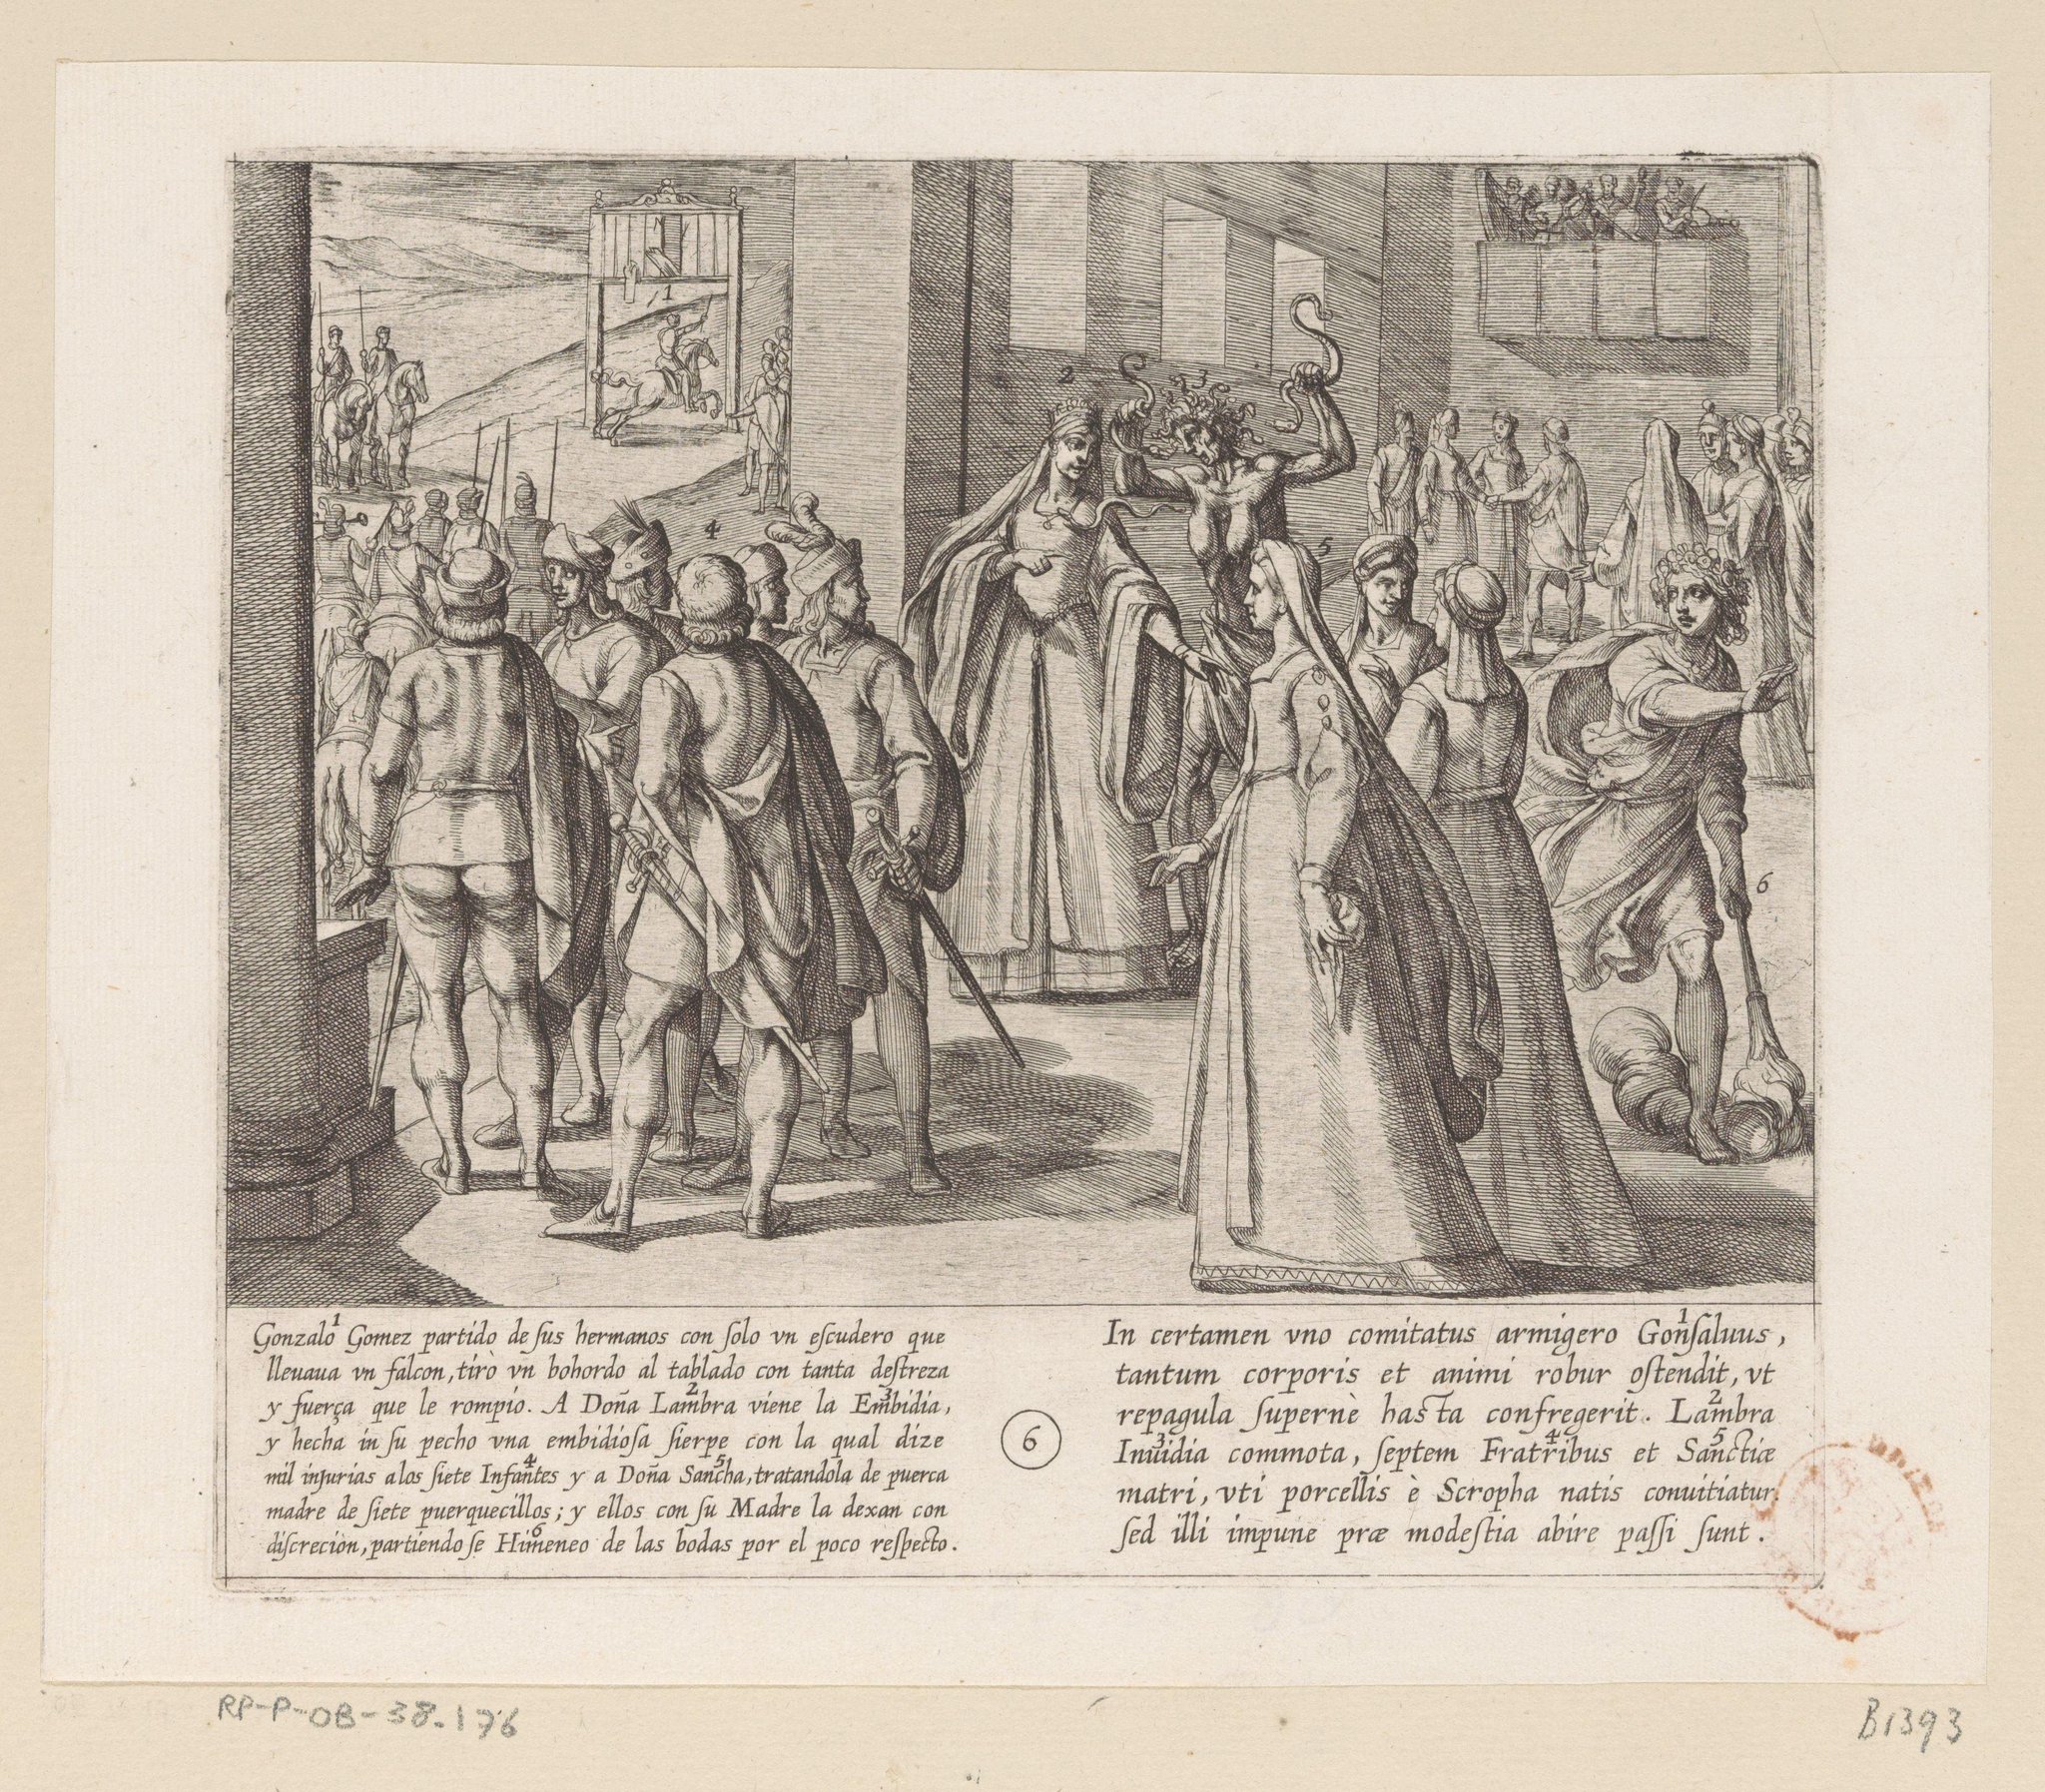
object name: print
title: Historia Septem Infantium de Lara/ Historia de los Siete Infantes de Lara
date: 1612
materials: paper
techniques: etching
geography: antwerp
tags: monsters of mixed human and animal shape; 'mostri' (ripa), palace, joust, tilt, tales and fairy tales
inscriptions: collector's mark: Lugt 240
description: Deze prent maakt deel uit van een reeks van 40 prenten (+ titelprent) met voorstellingen uit het volksverhaal over de zeven infanten van Lara.